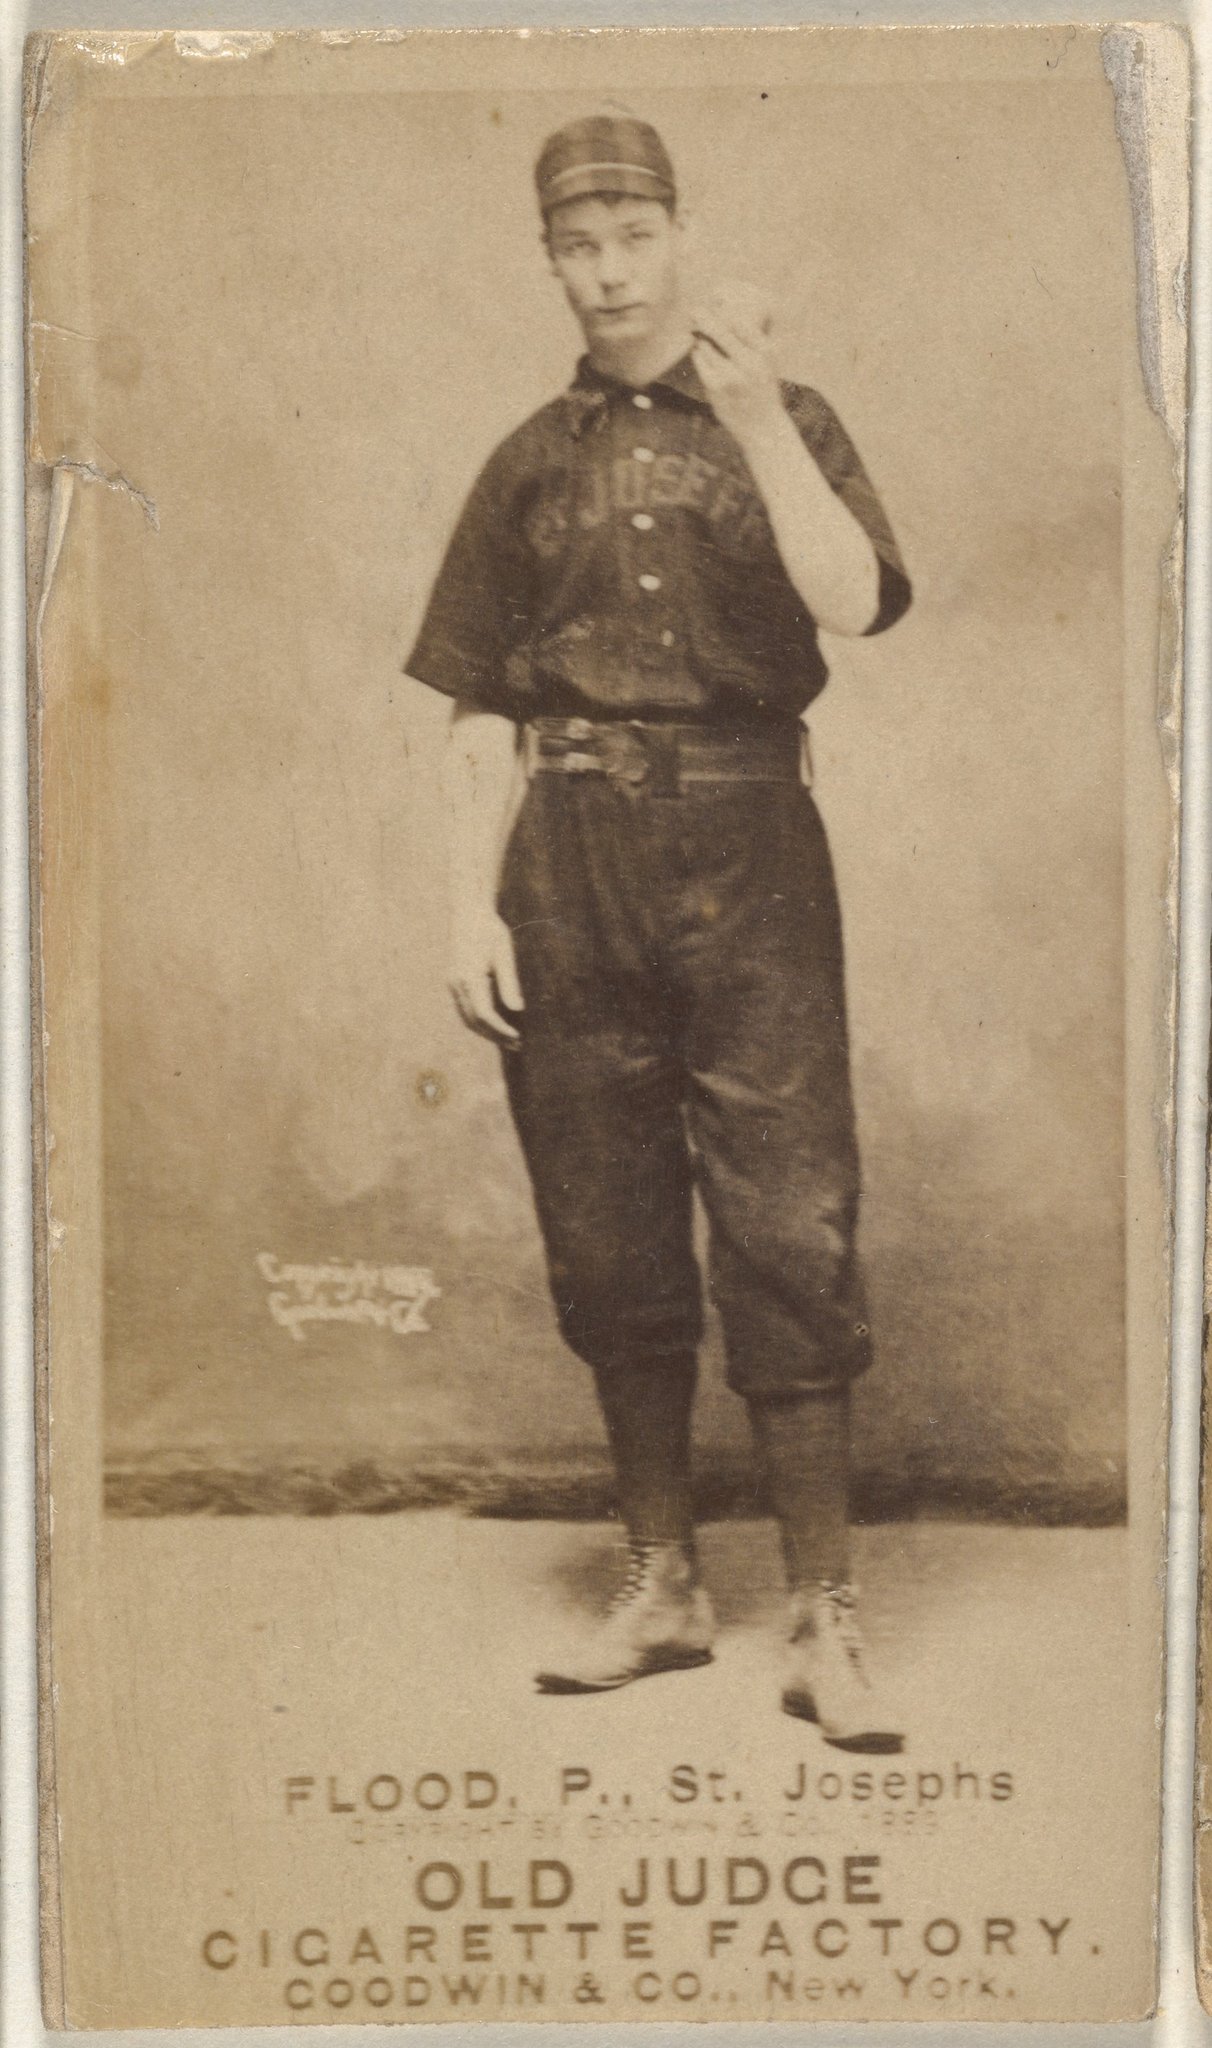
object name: baseball card, photograph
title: Thomas J. Flood, Pitcher, St. Joseph Clay Eaters, from the Old Judge series (N172) for Old Judge Cigarettes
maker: goodwin & company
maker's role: publisher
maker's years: 1850-1950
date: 1889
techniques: albumen silver print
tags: men,portraits,baseball,athletes